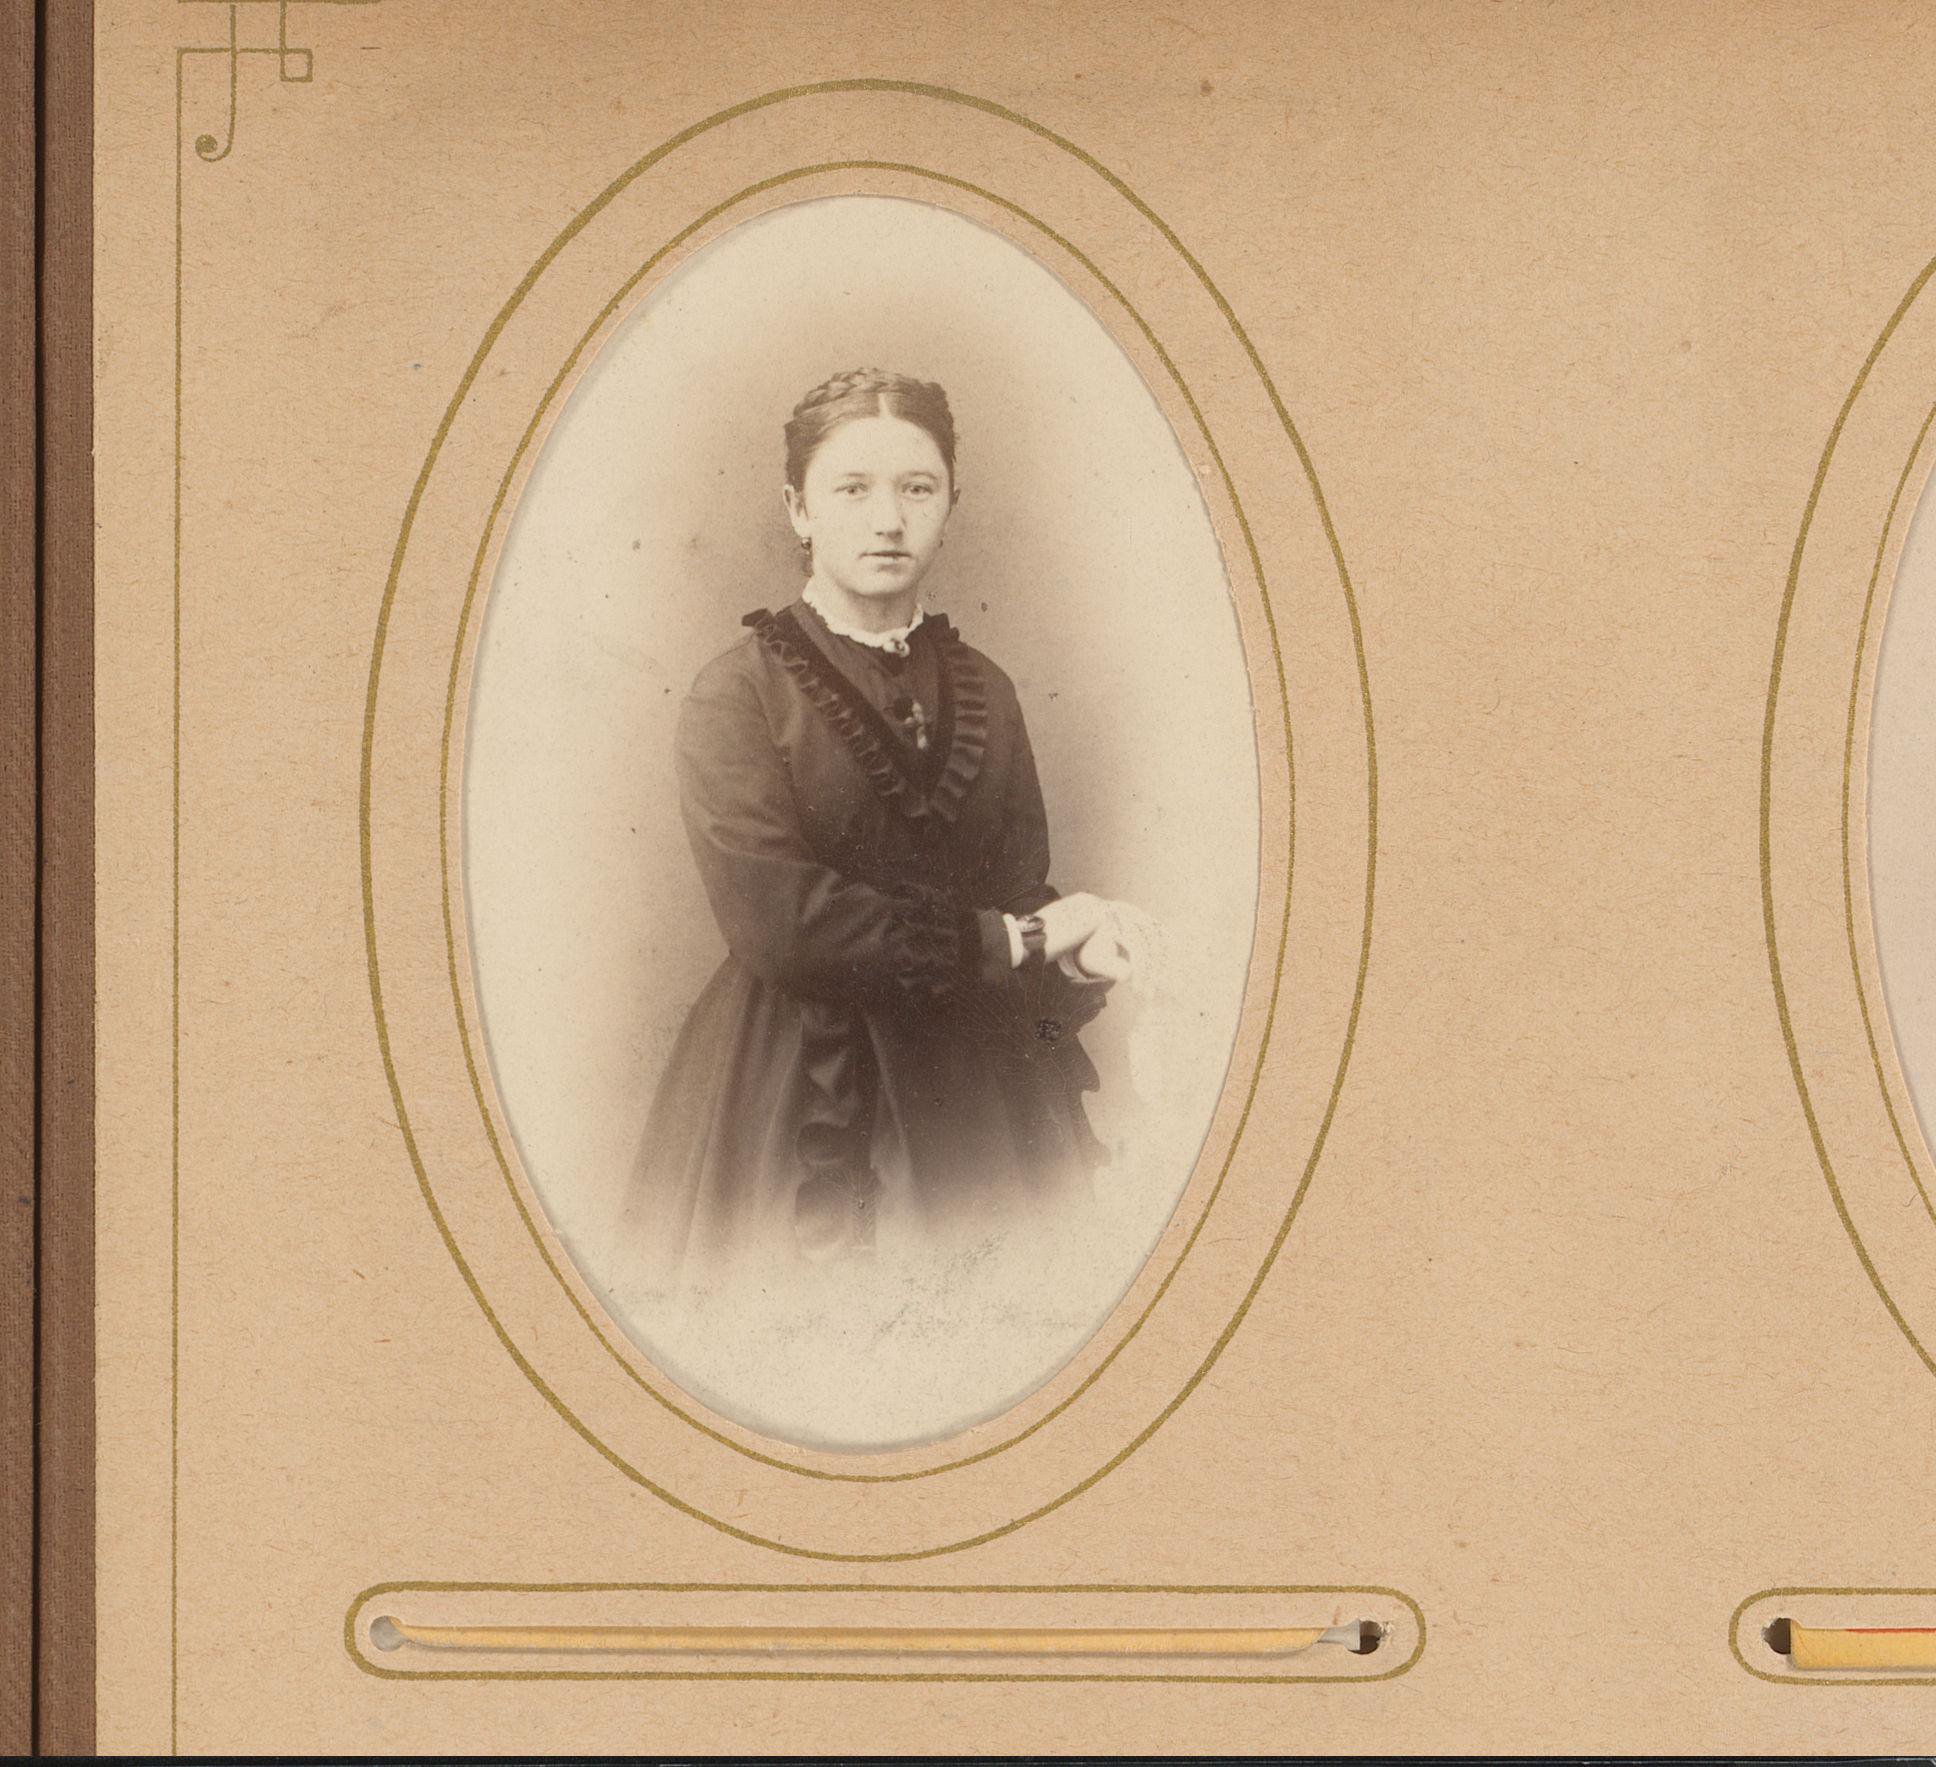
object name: carte de visite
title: Portret van een staande jonge vrouw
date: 1860-1900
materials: cardboard, photographic support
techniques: albumen print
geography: chemnitz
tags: adolescent, young woman, maiden, historical persons - bb - woman, standing figure - aa - female human figure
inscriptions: inscription: ‘Photographisches/ Atelier/ von/ F. Jordan & Co./ in/ CHEMNITZ/ Zwickauerstrasse 1,/ im Garten der Nicolai-Apotheke.’